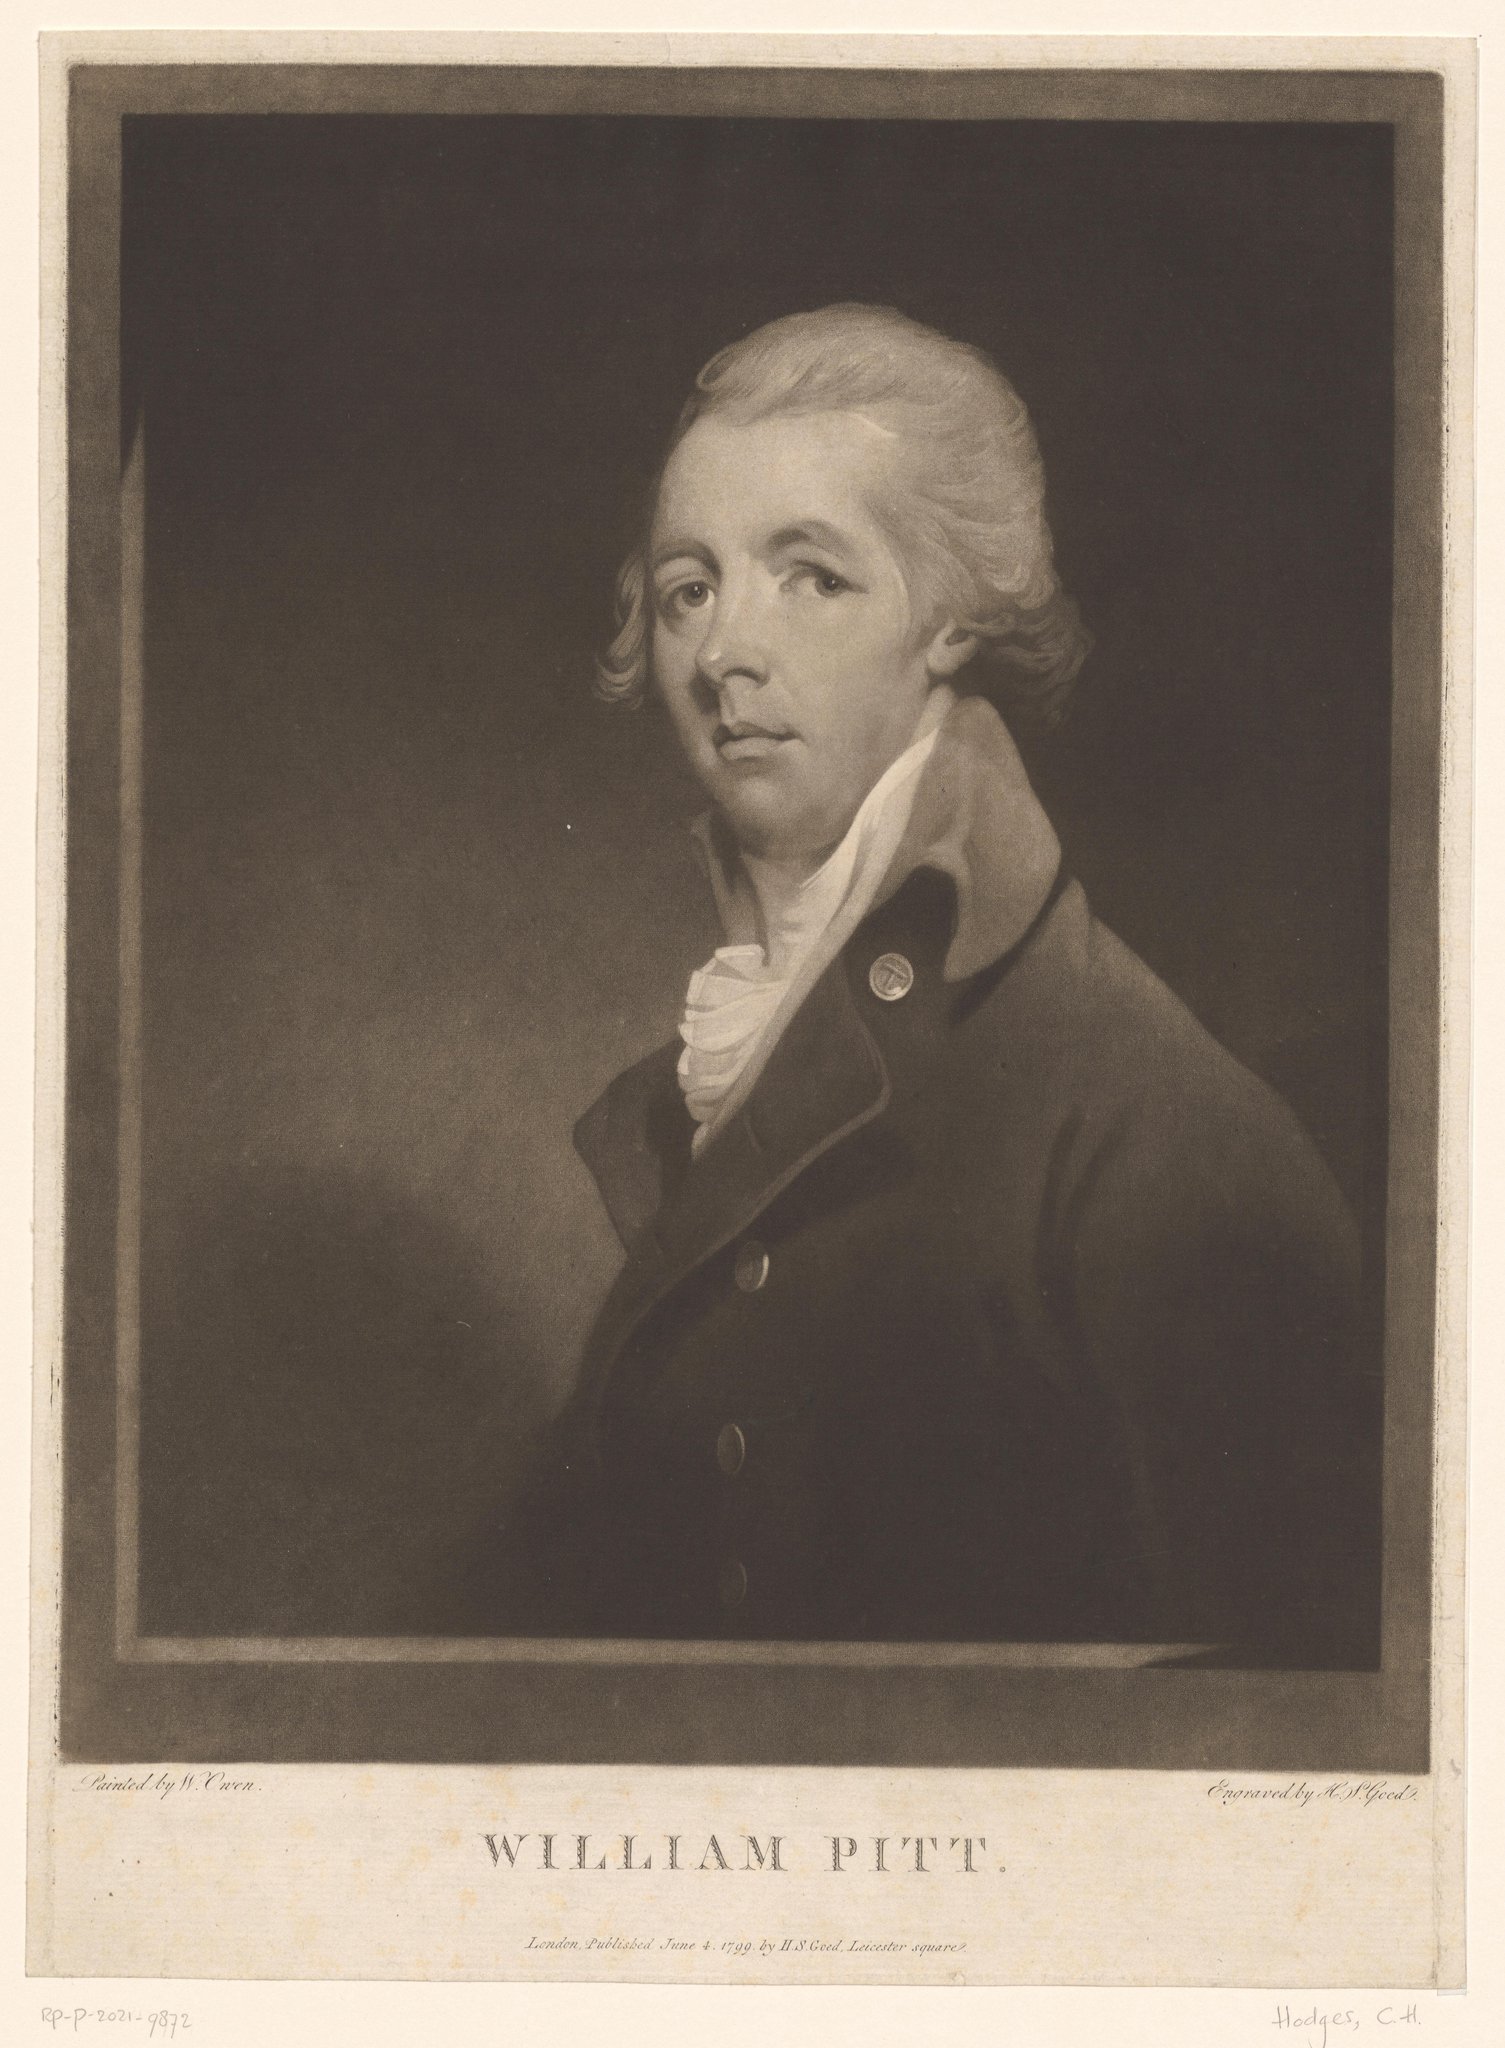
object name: print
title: Portret van William Pitt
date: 1799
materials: paper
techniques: engraving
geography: london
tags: london, adult man, historical persons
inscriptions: collector's mark: Lugt 964